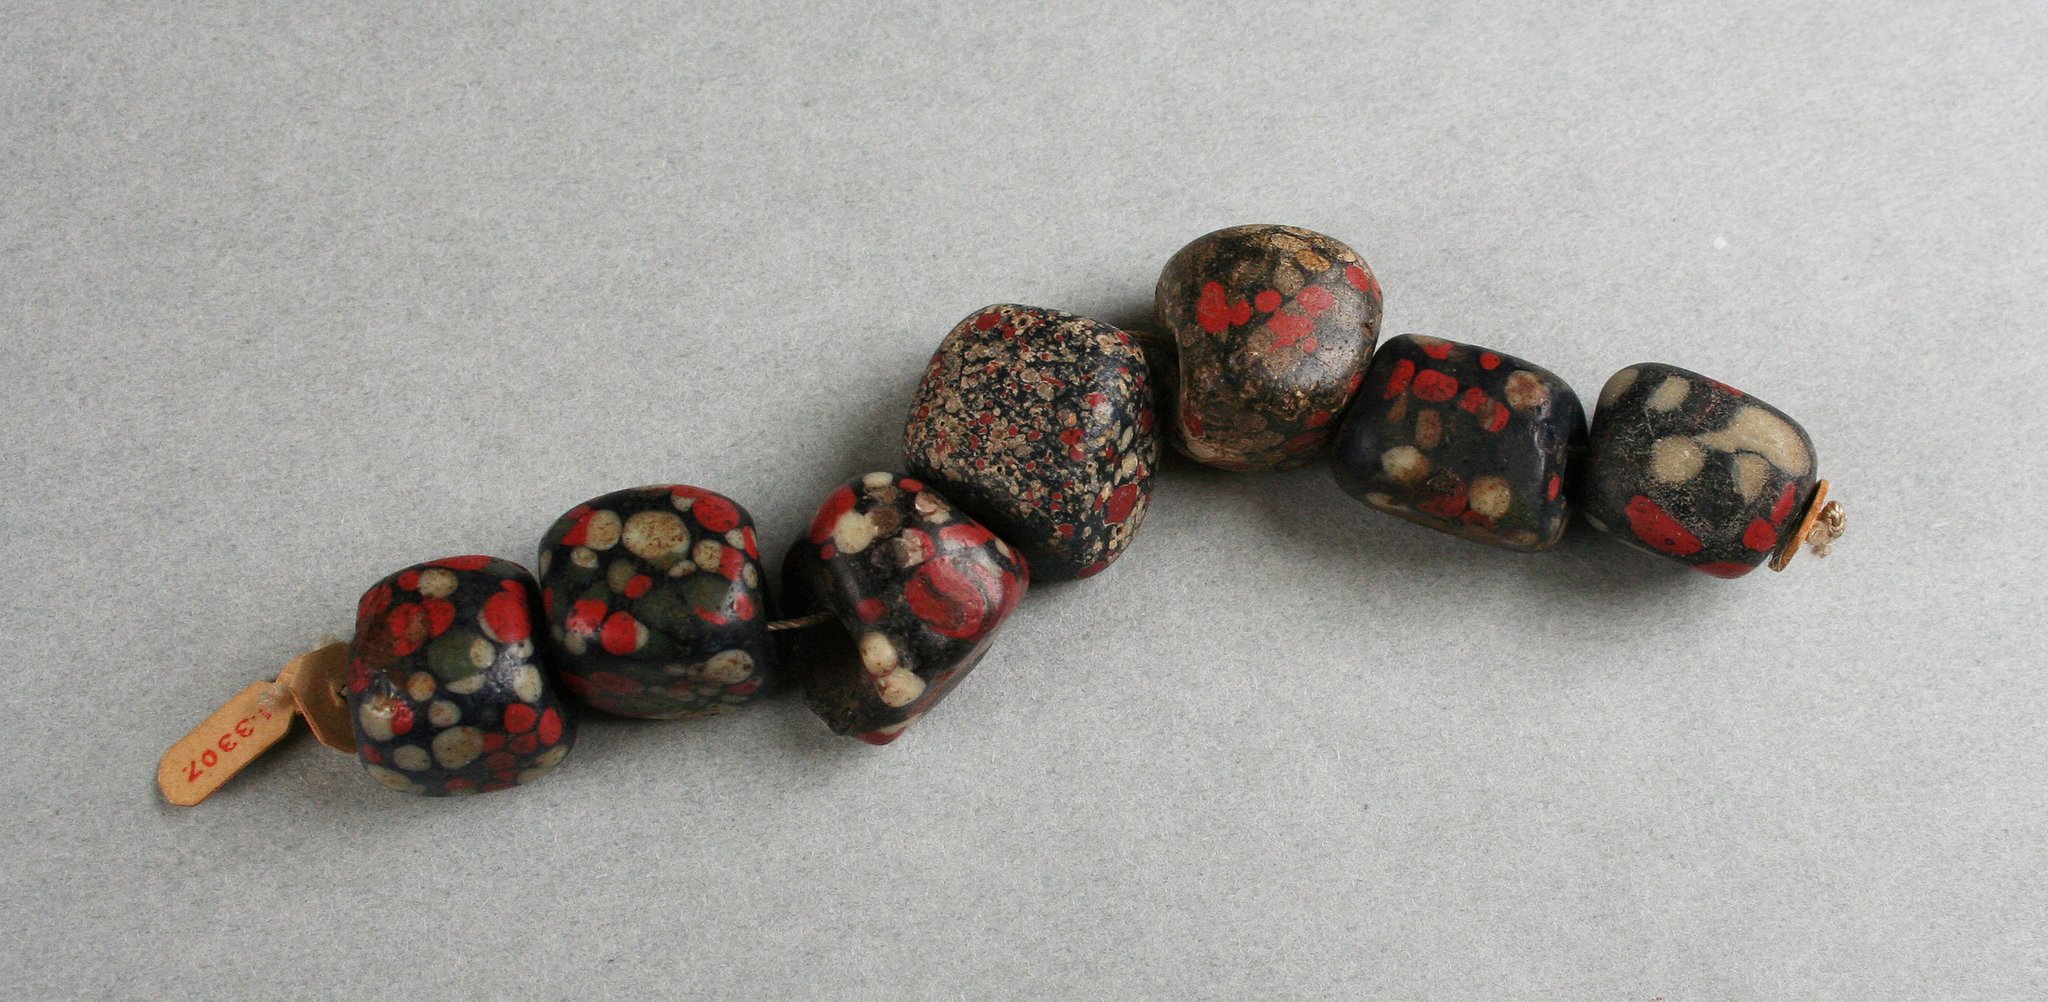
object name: bead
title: Beads, string of seven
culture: african or european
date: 1701-1800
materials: glass